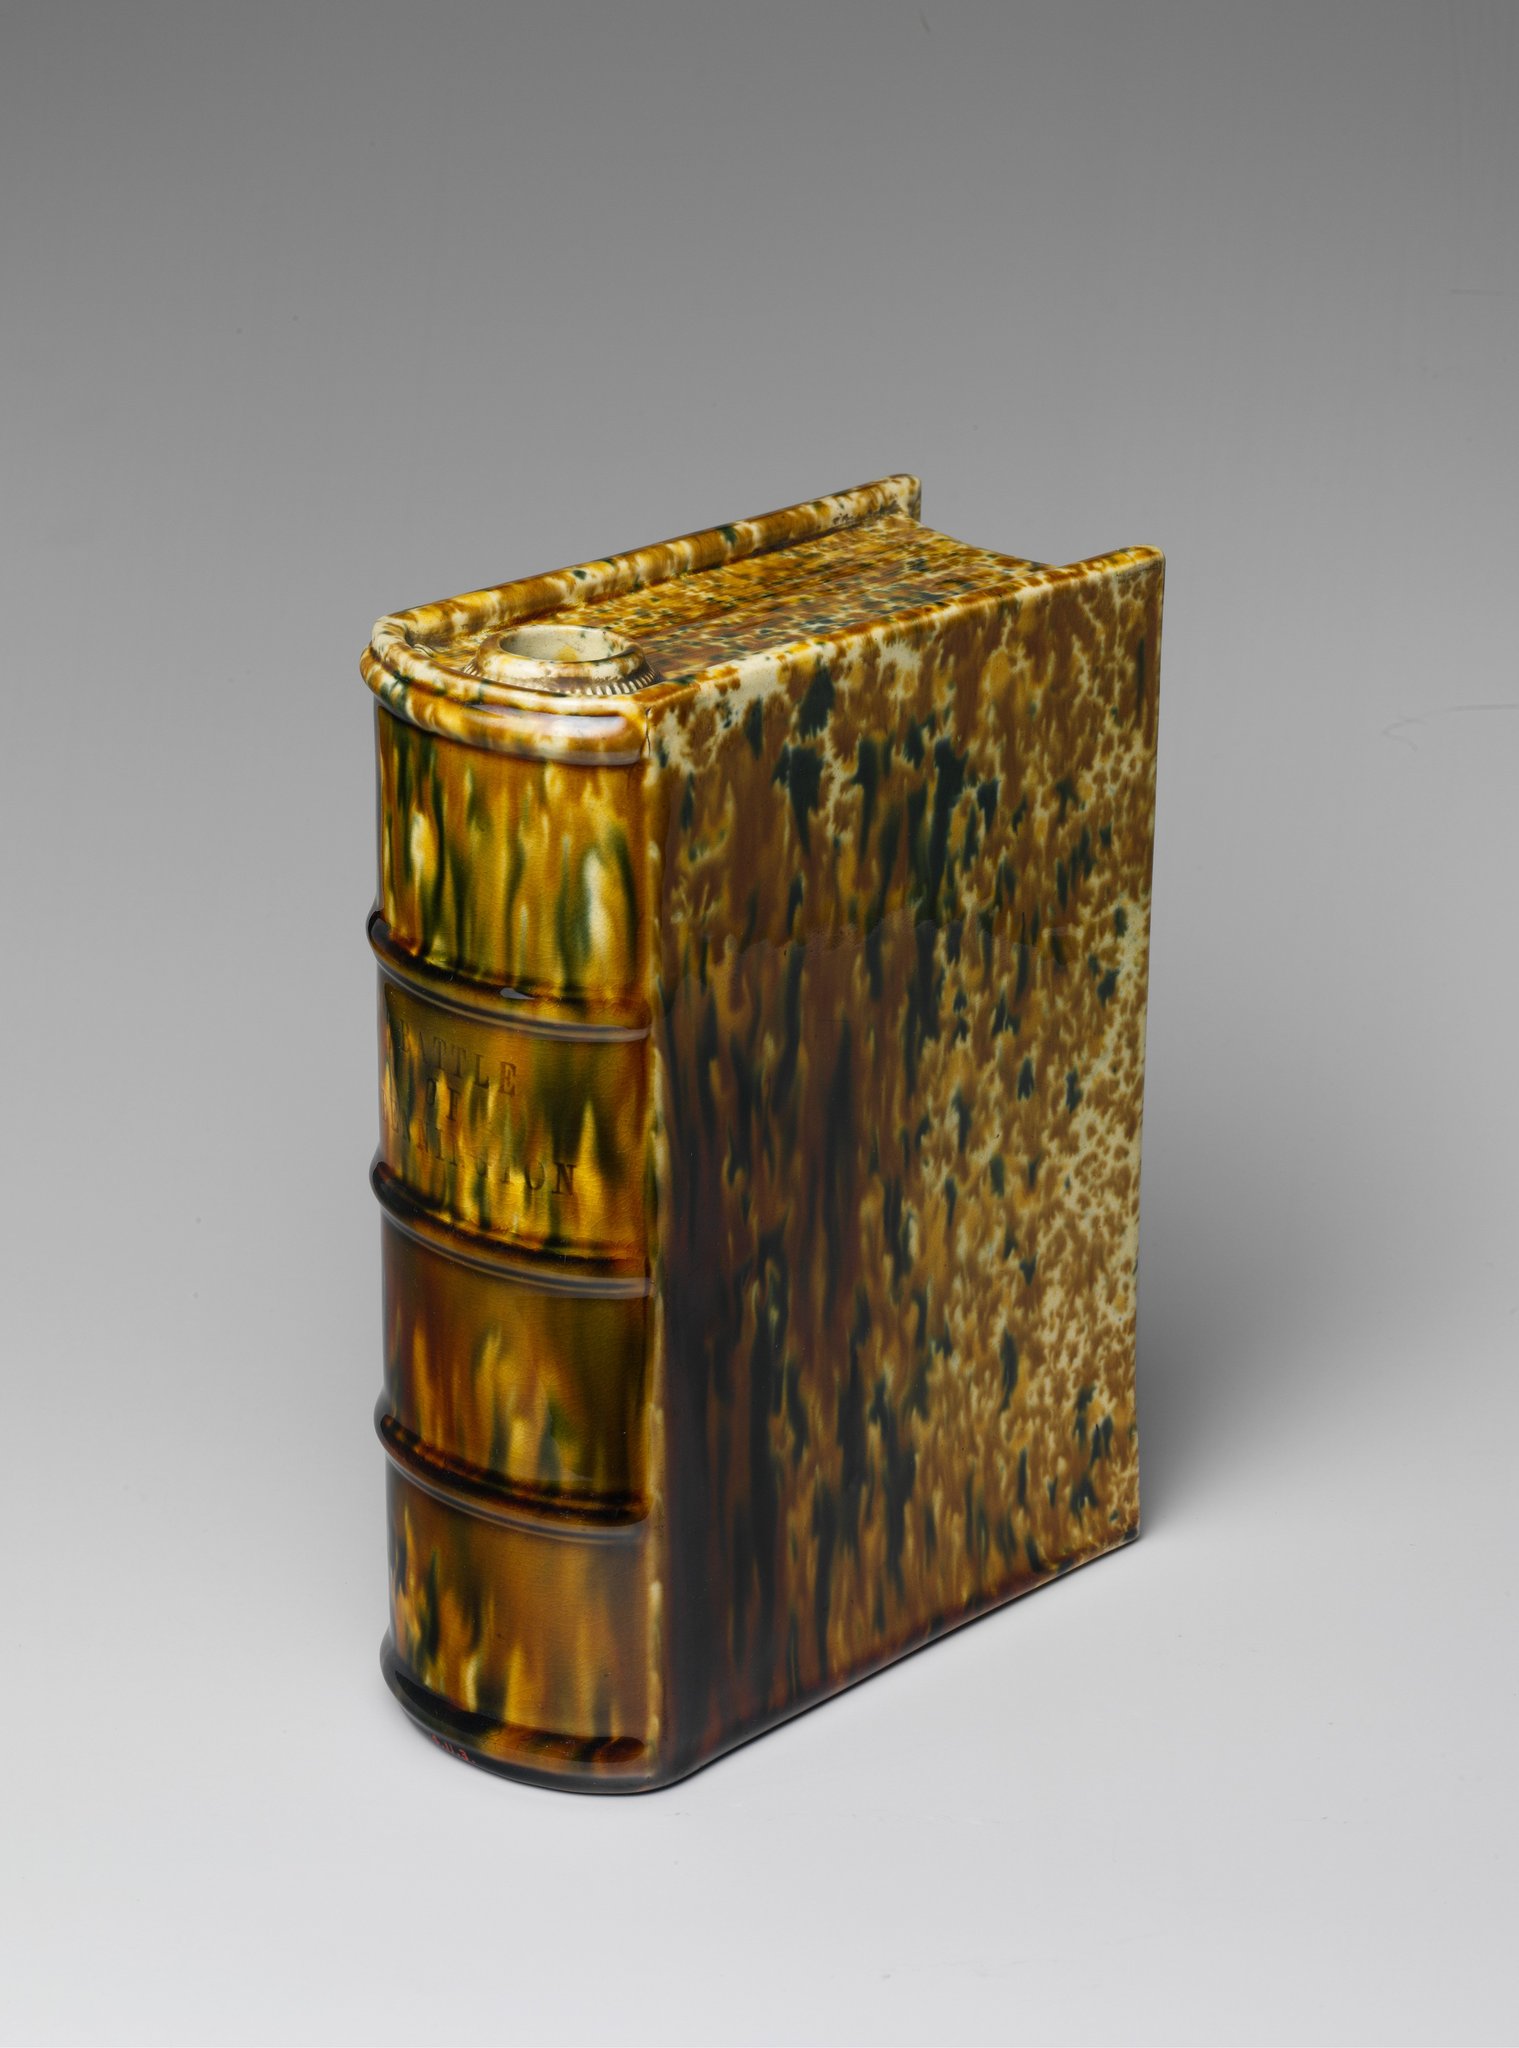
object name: flask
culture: american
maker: united states pottery company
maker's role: maker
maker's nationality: american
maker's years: 1852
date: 1853-1858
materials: earthenware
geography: united states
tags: books